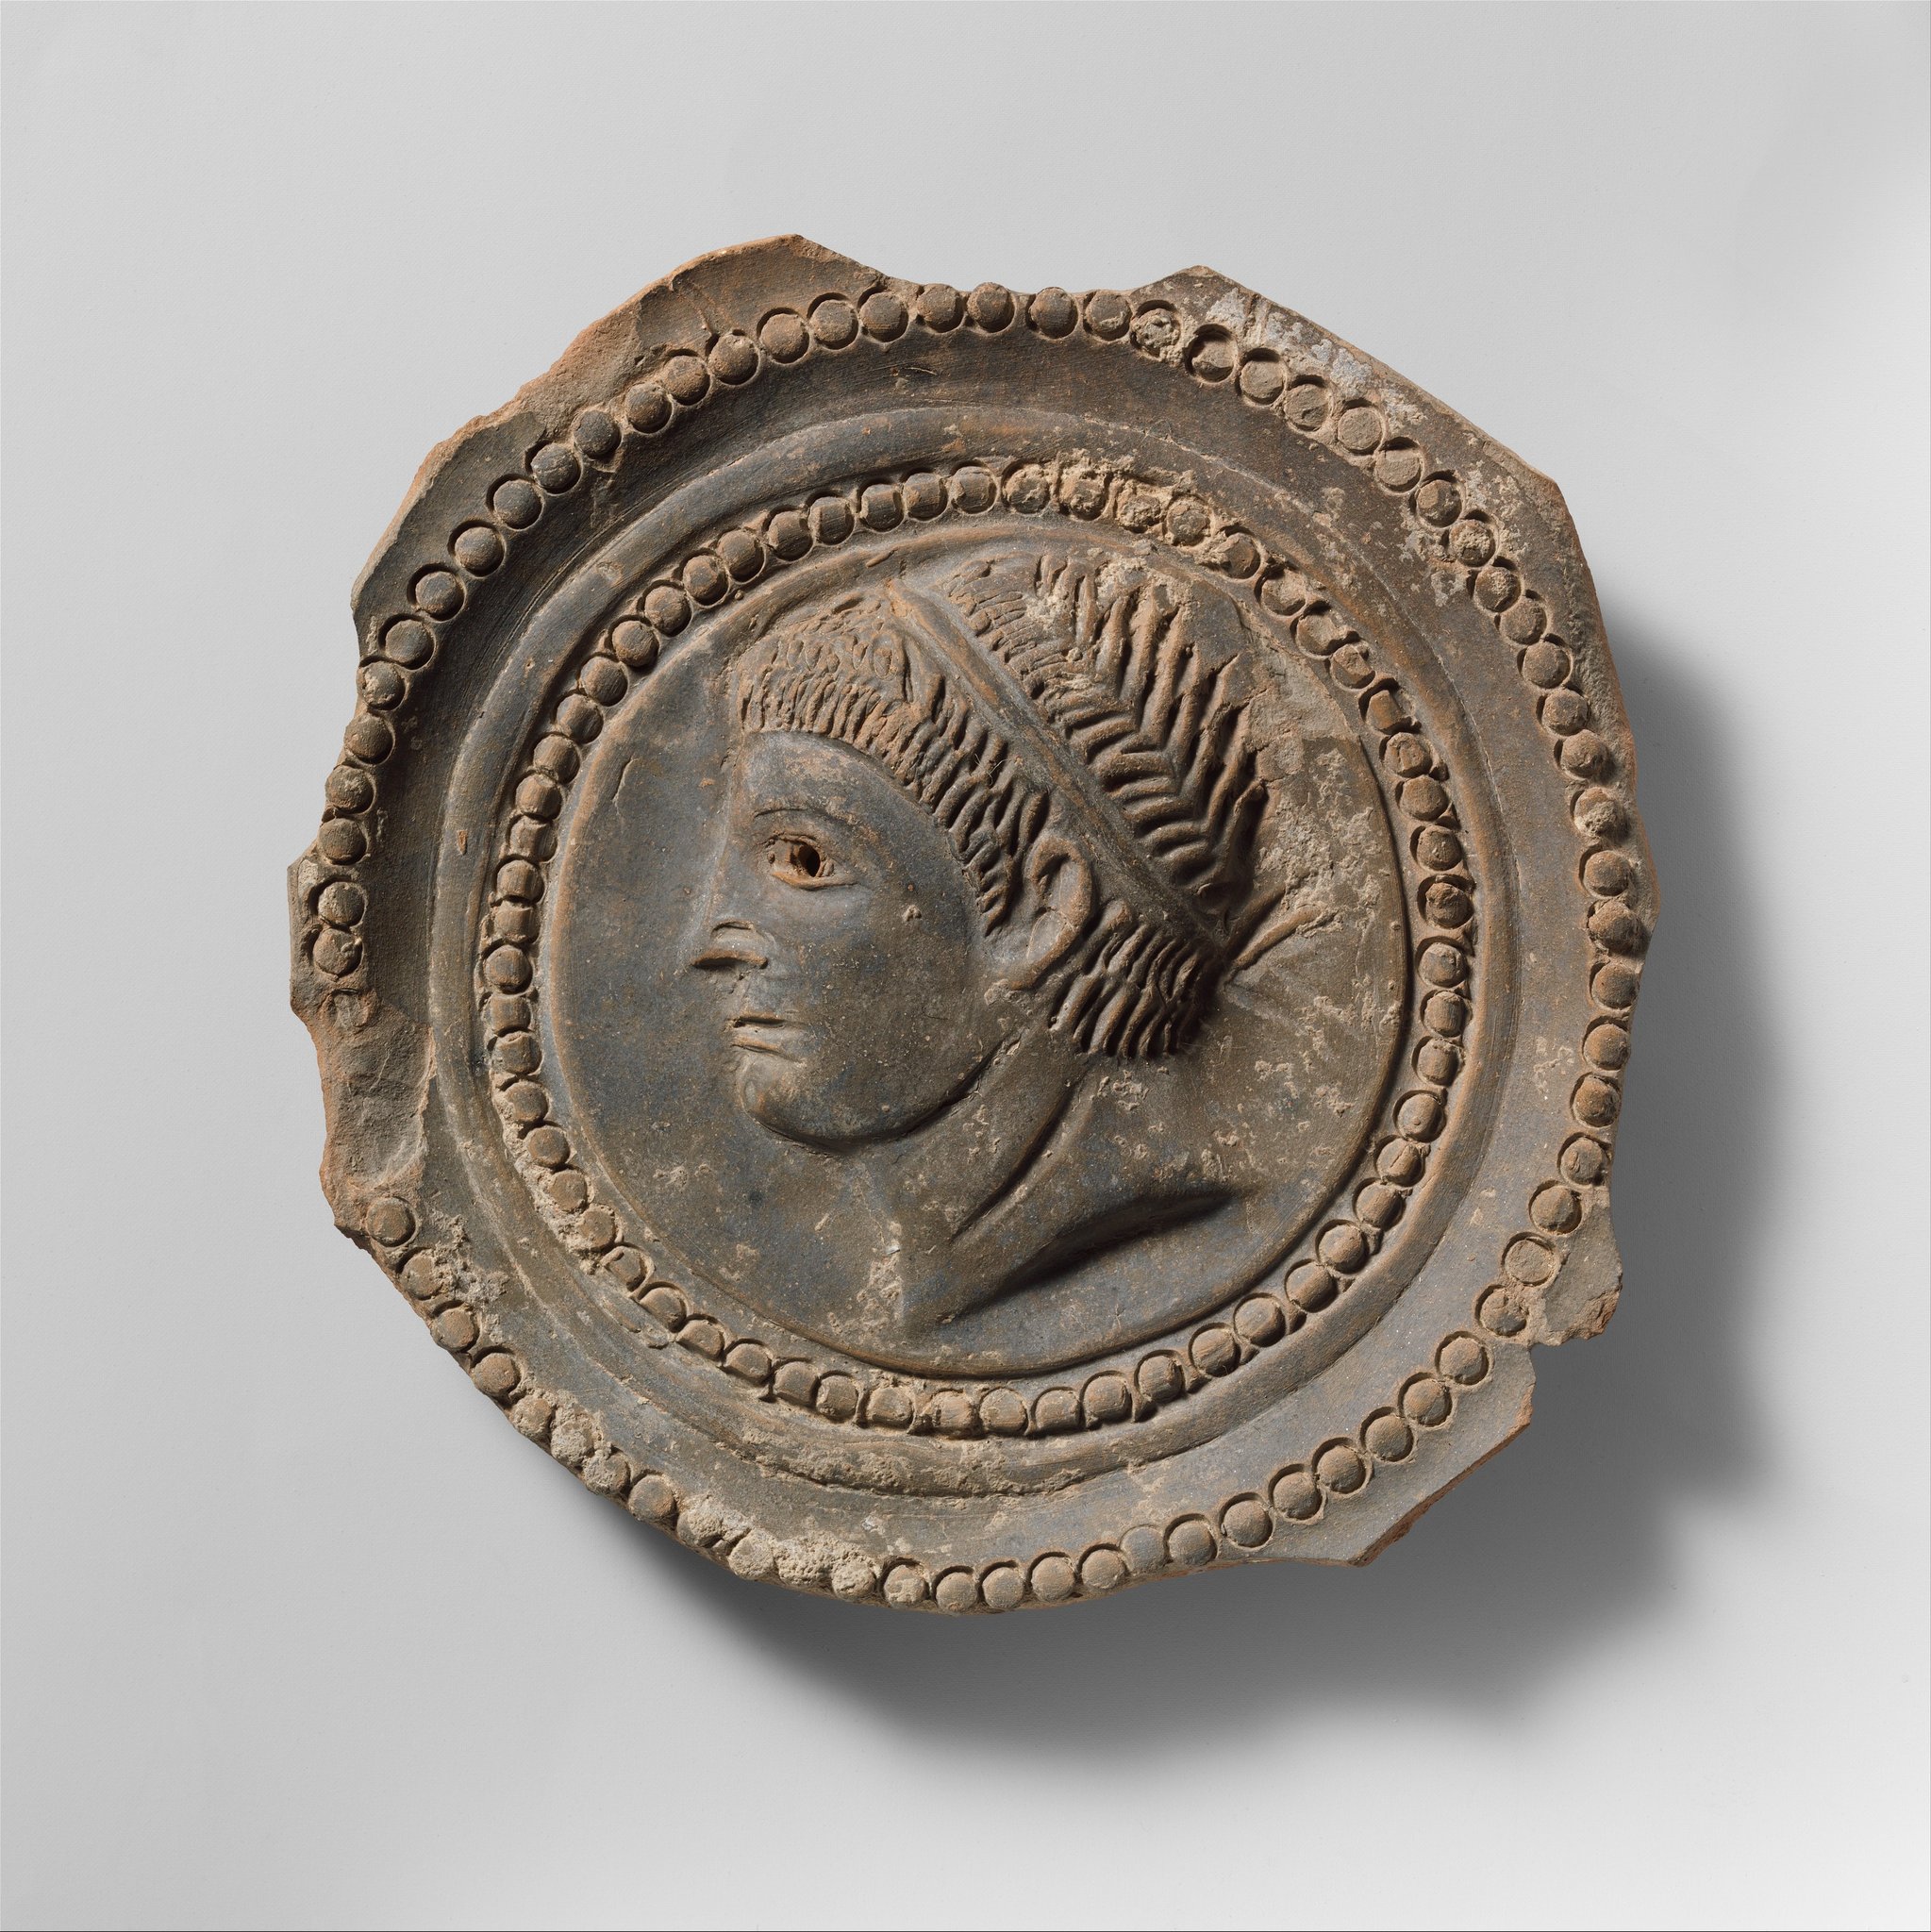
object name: plate with relief head, fragmentary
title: Fragmentary terracotta bowl with tondo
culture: roman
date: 67-166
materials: terracotta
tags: heads,men,profiles